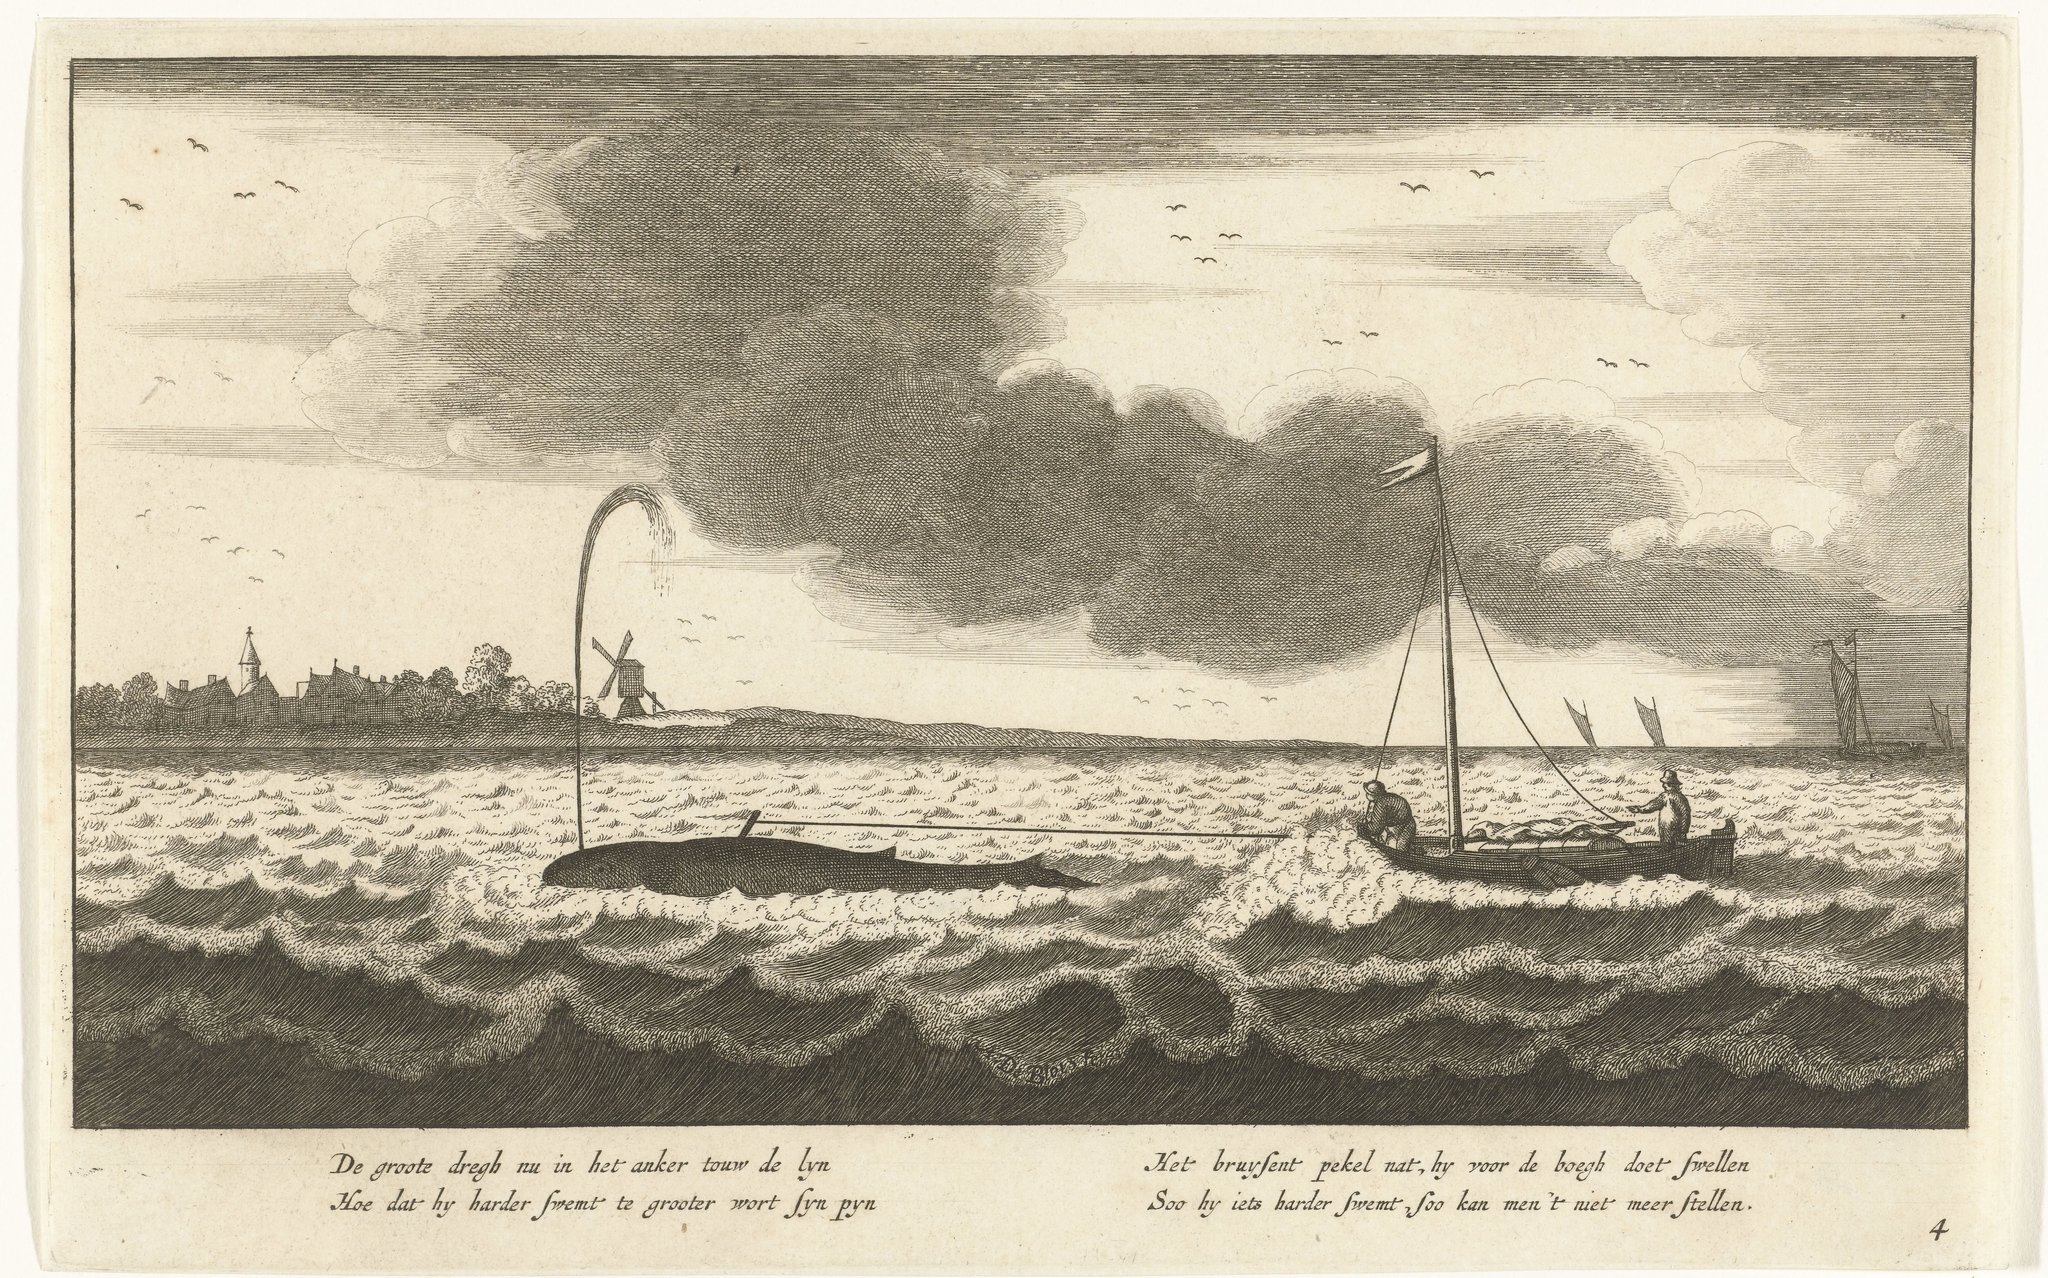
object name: print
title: De walvis aan een lijn, 1682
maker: abraham de blois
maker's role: print maker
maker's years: 1679-1717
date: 1682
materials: paper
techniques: etching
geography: northern netherlands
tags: whale fishery, whaling, swimming mammals: whale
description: De walvis aan een lijn van de visser Abr. Jansz. van Oelen en zijn zoon. In het onderschrift een vers van 4 regels. Prent nr. 4 in een serie van zes prenten over het vangen van een walvis bij Sint Annaland op het eiland Tholen, 7 oktober 1682.